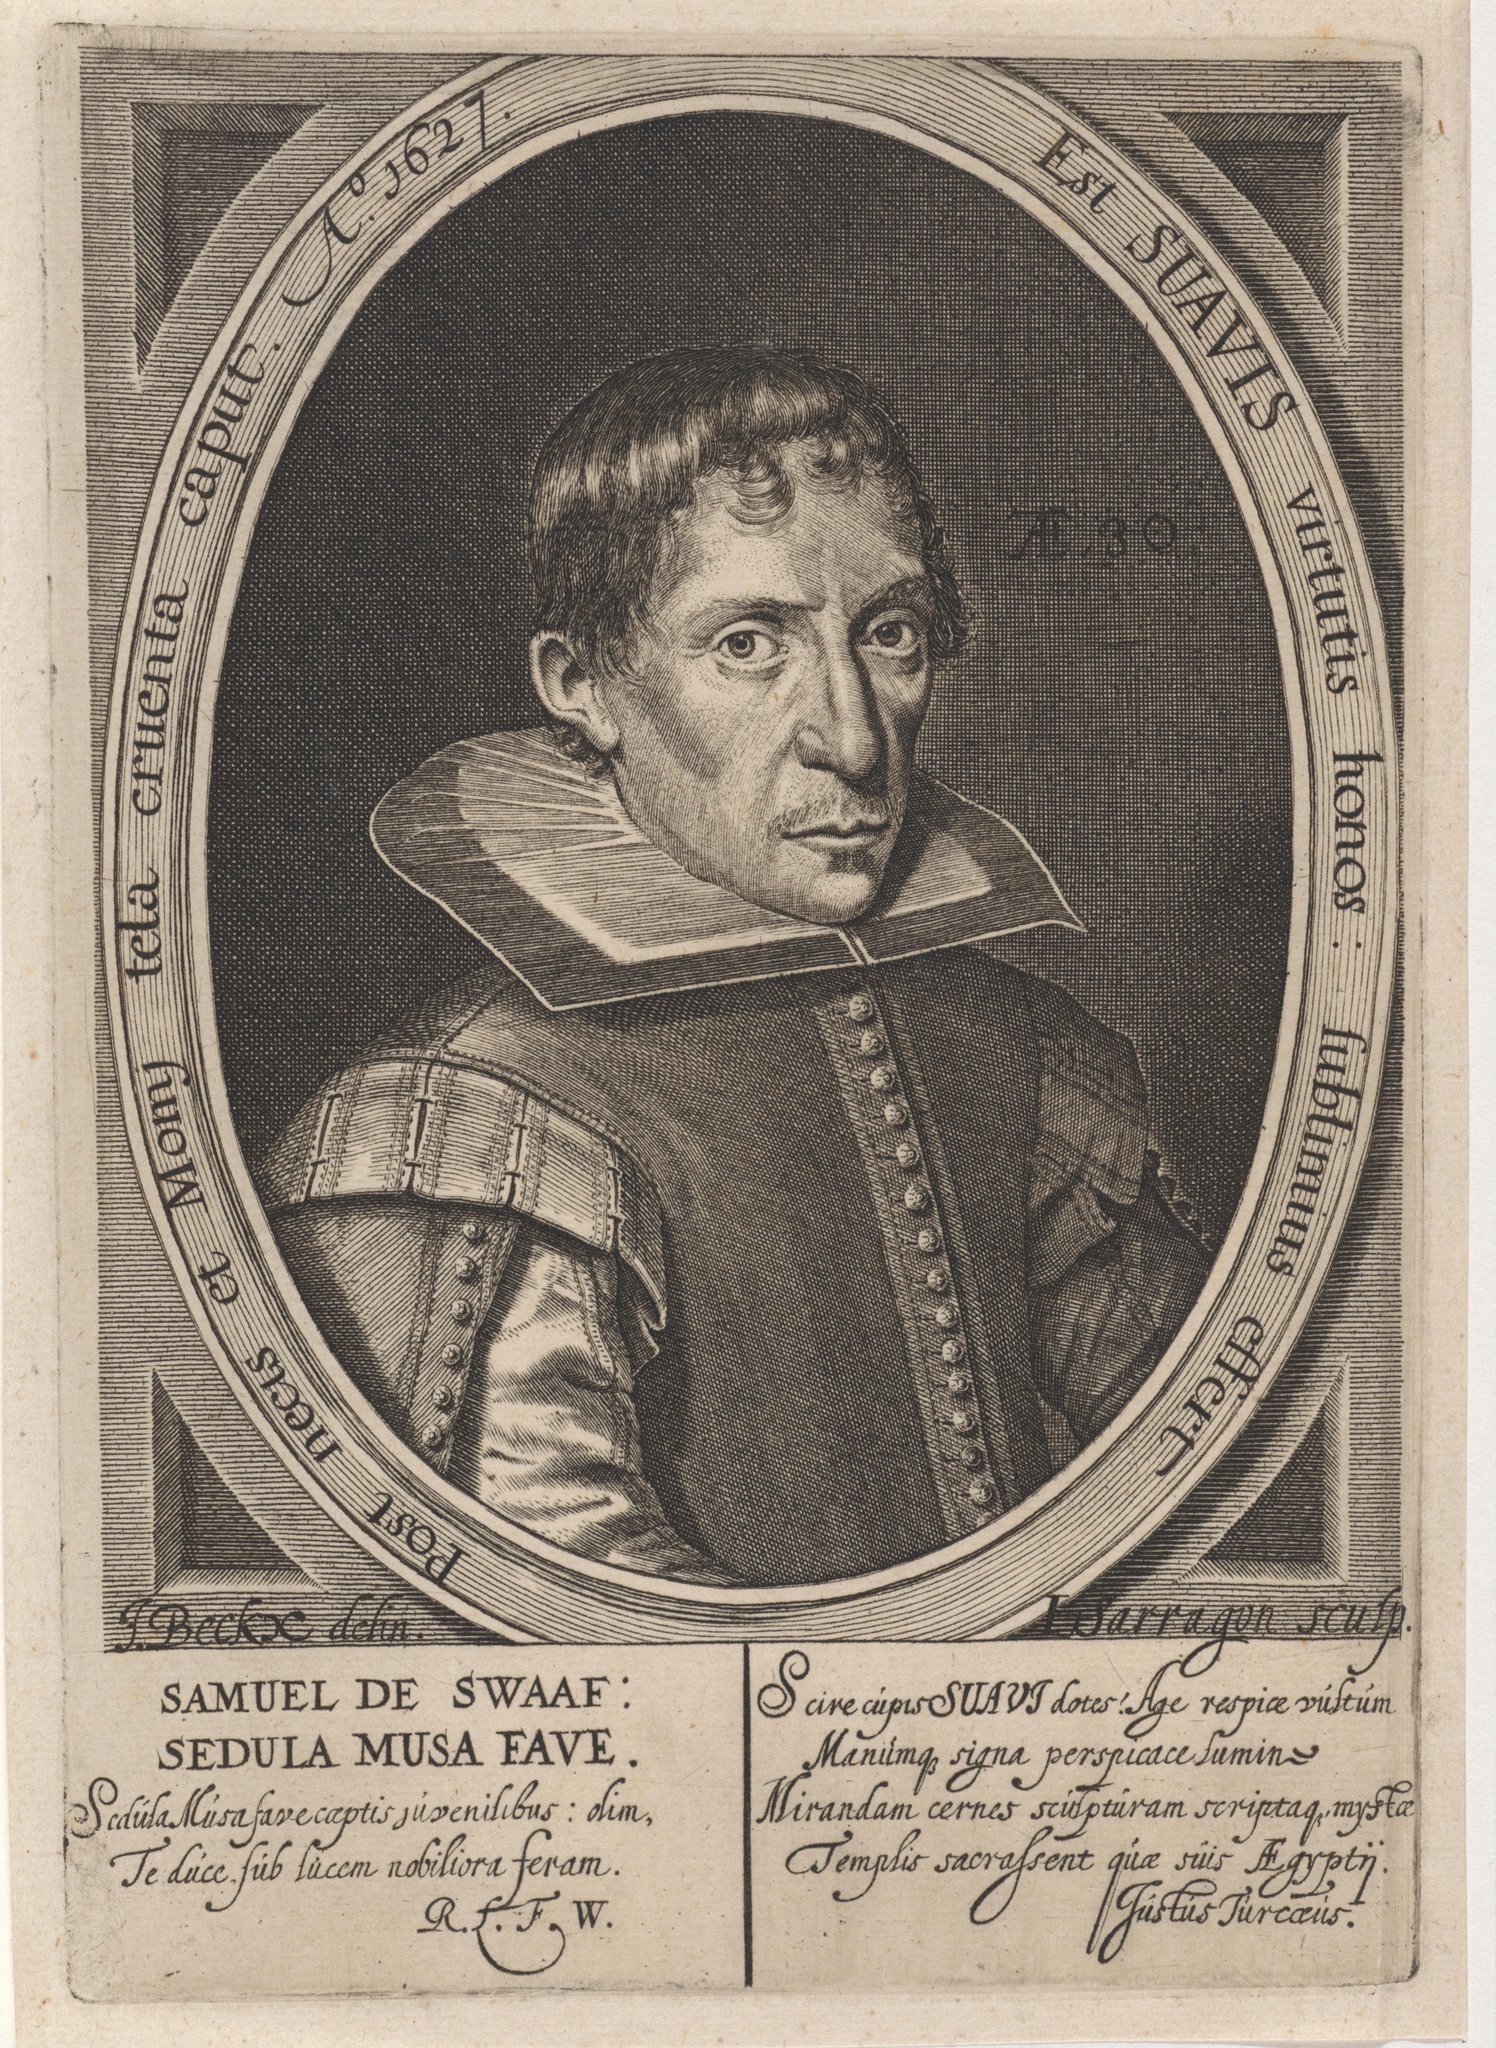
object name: print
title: Portret van Samuel de Swaef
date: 1627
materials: paper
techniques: engraving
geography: middelburg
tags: middelburg, print maker, samuel de swaef, historical persons, portrait, self-portrait of graphic artist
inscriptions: collector's mark: Lugt 2228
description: Buste naar rechts van de kunstenaar Samuel de Swaef in een omlijsting met Latijns randschrift. Het randschrift bevat informatie over de geportretteerde. Daaronder een anagram van zijn naam met een tweeregelige, Latijnse tekst en rechtsonder nog een vierregelige tekst in het Latijn.